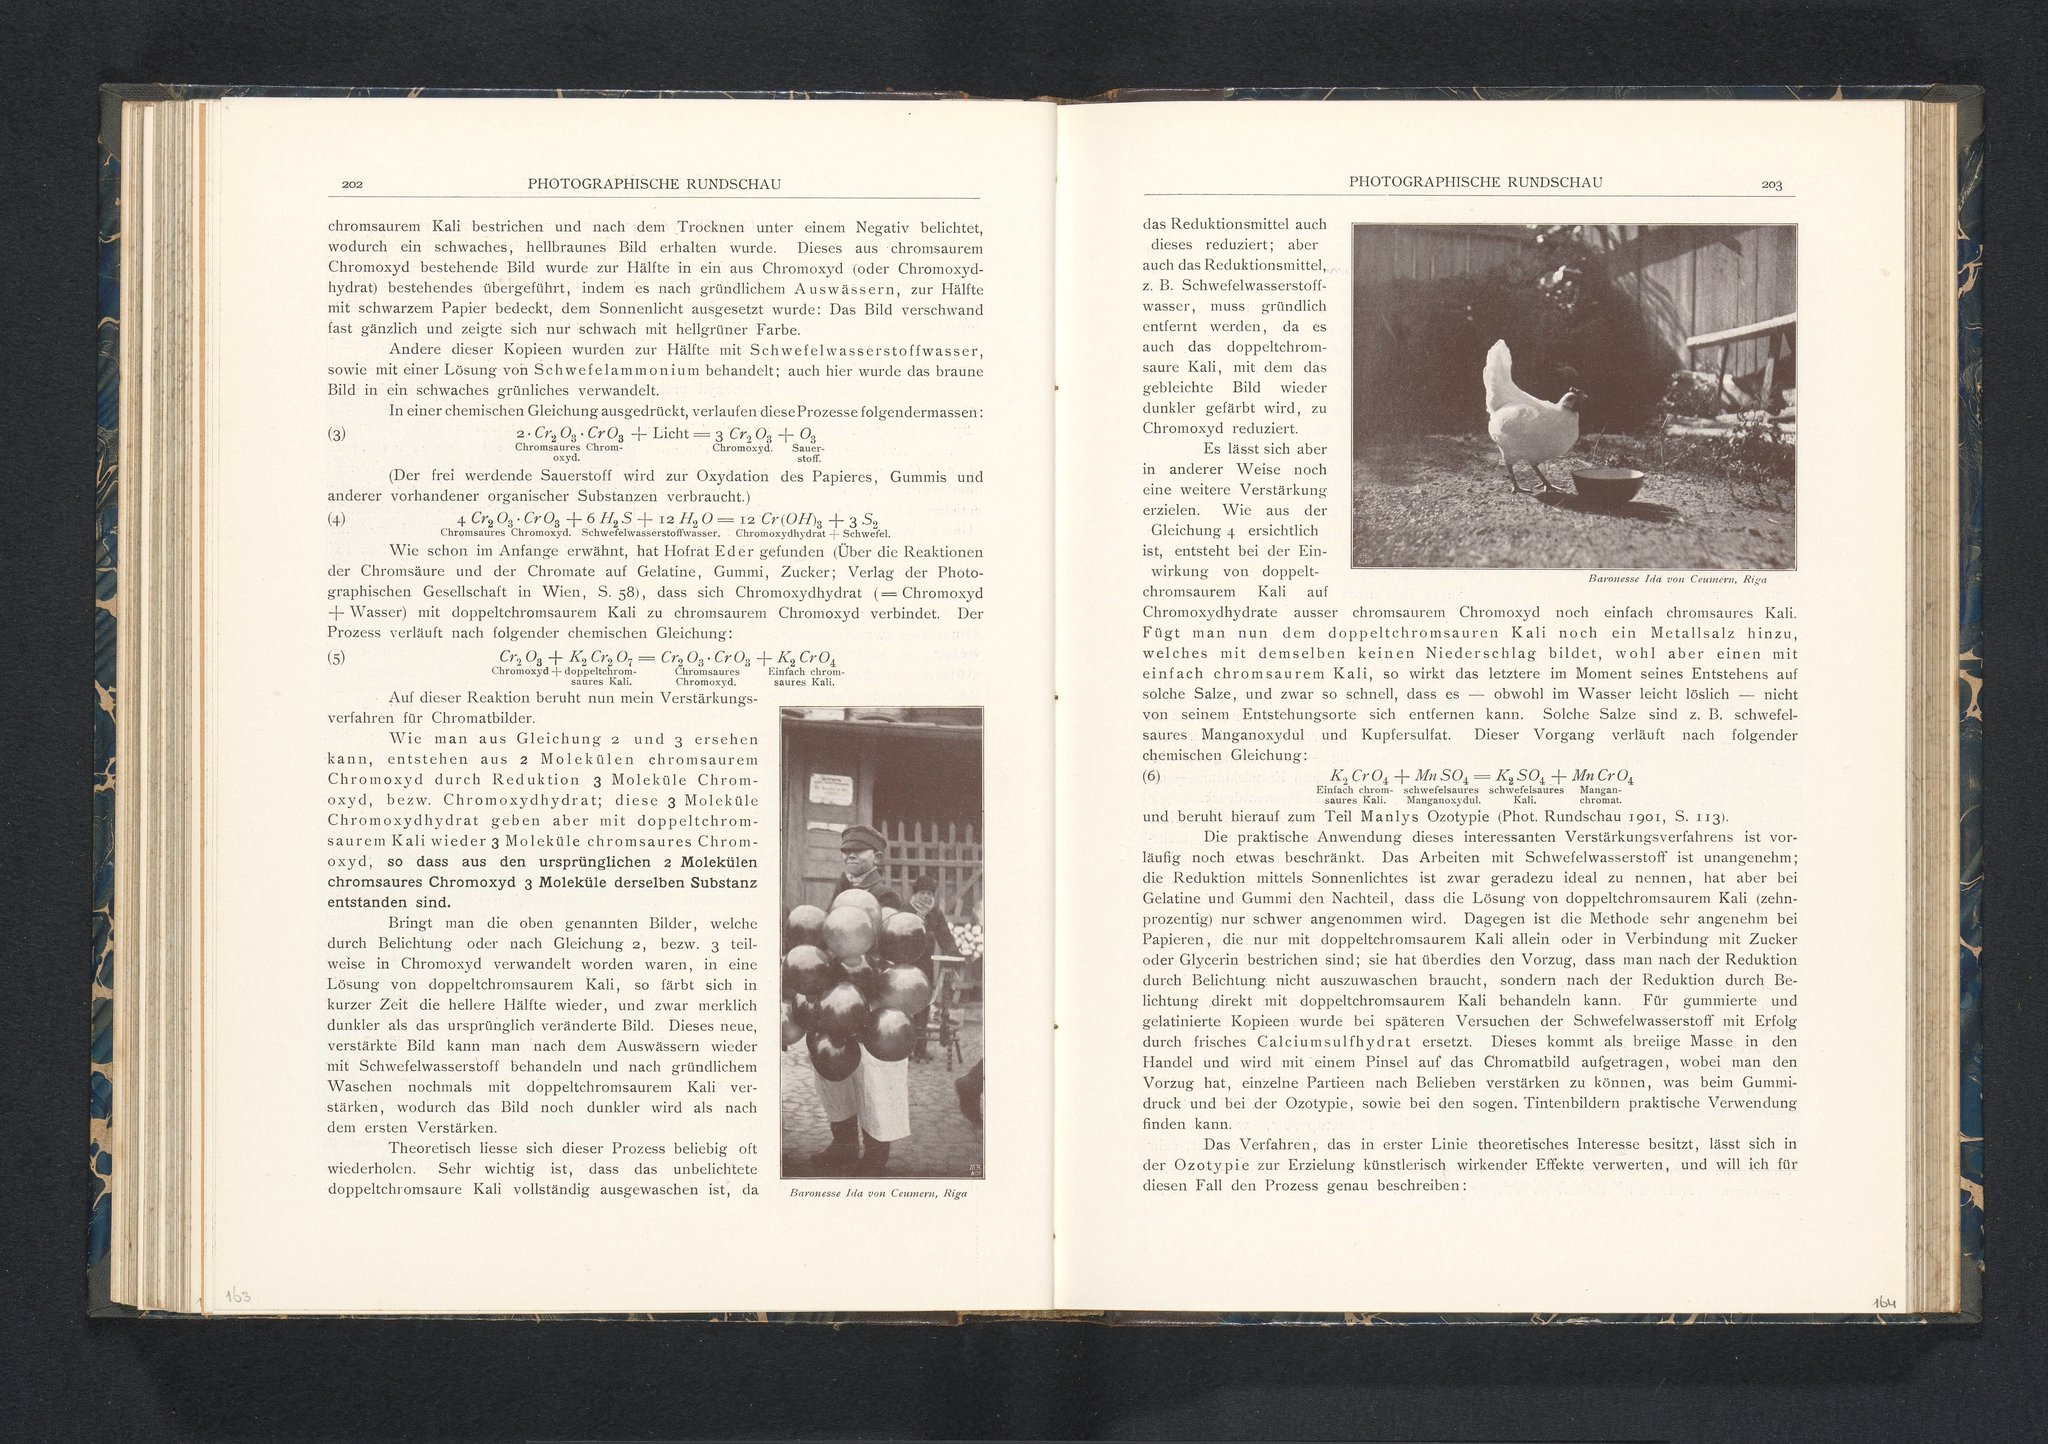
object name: page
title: Jongen met ballonnen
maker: ida von ceumern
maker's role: barones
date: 1896-1901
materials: paper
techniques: autotype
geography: berlin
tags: historical persons not known by name